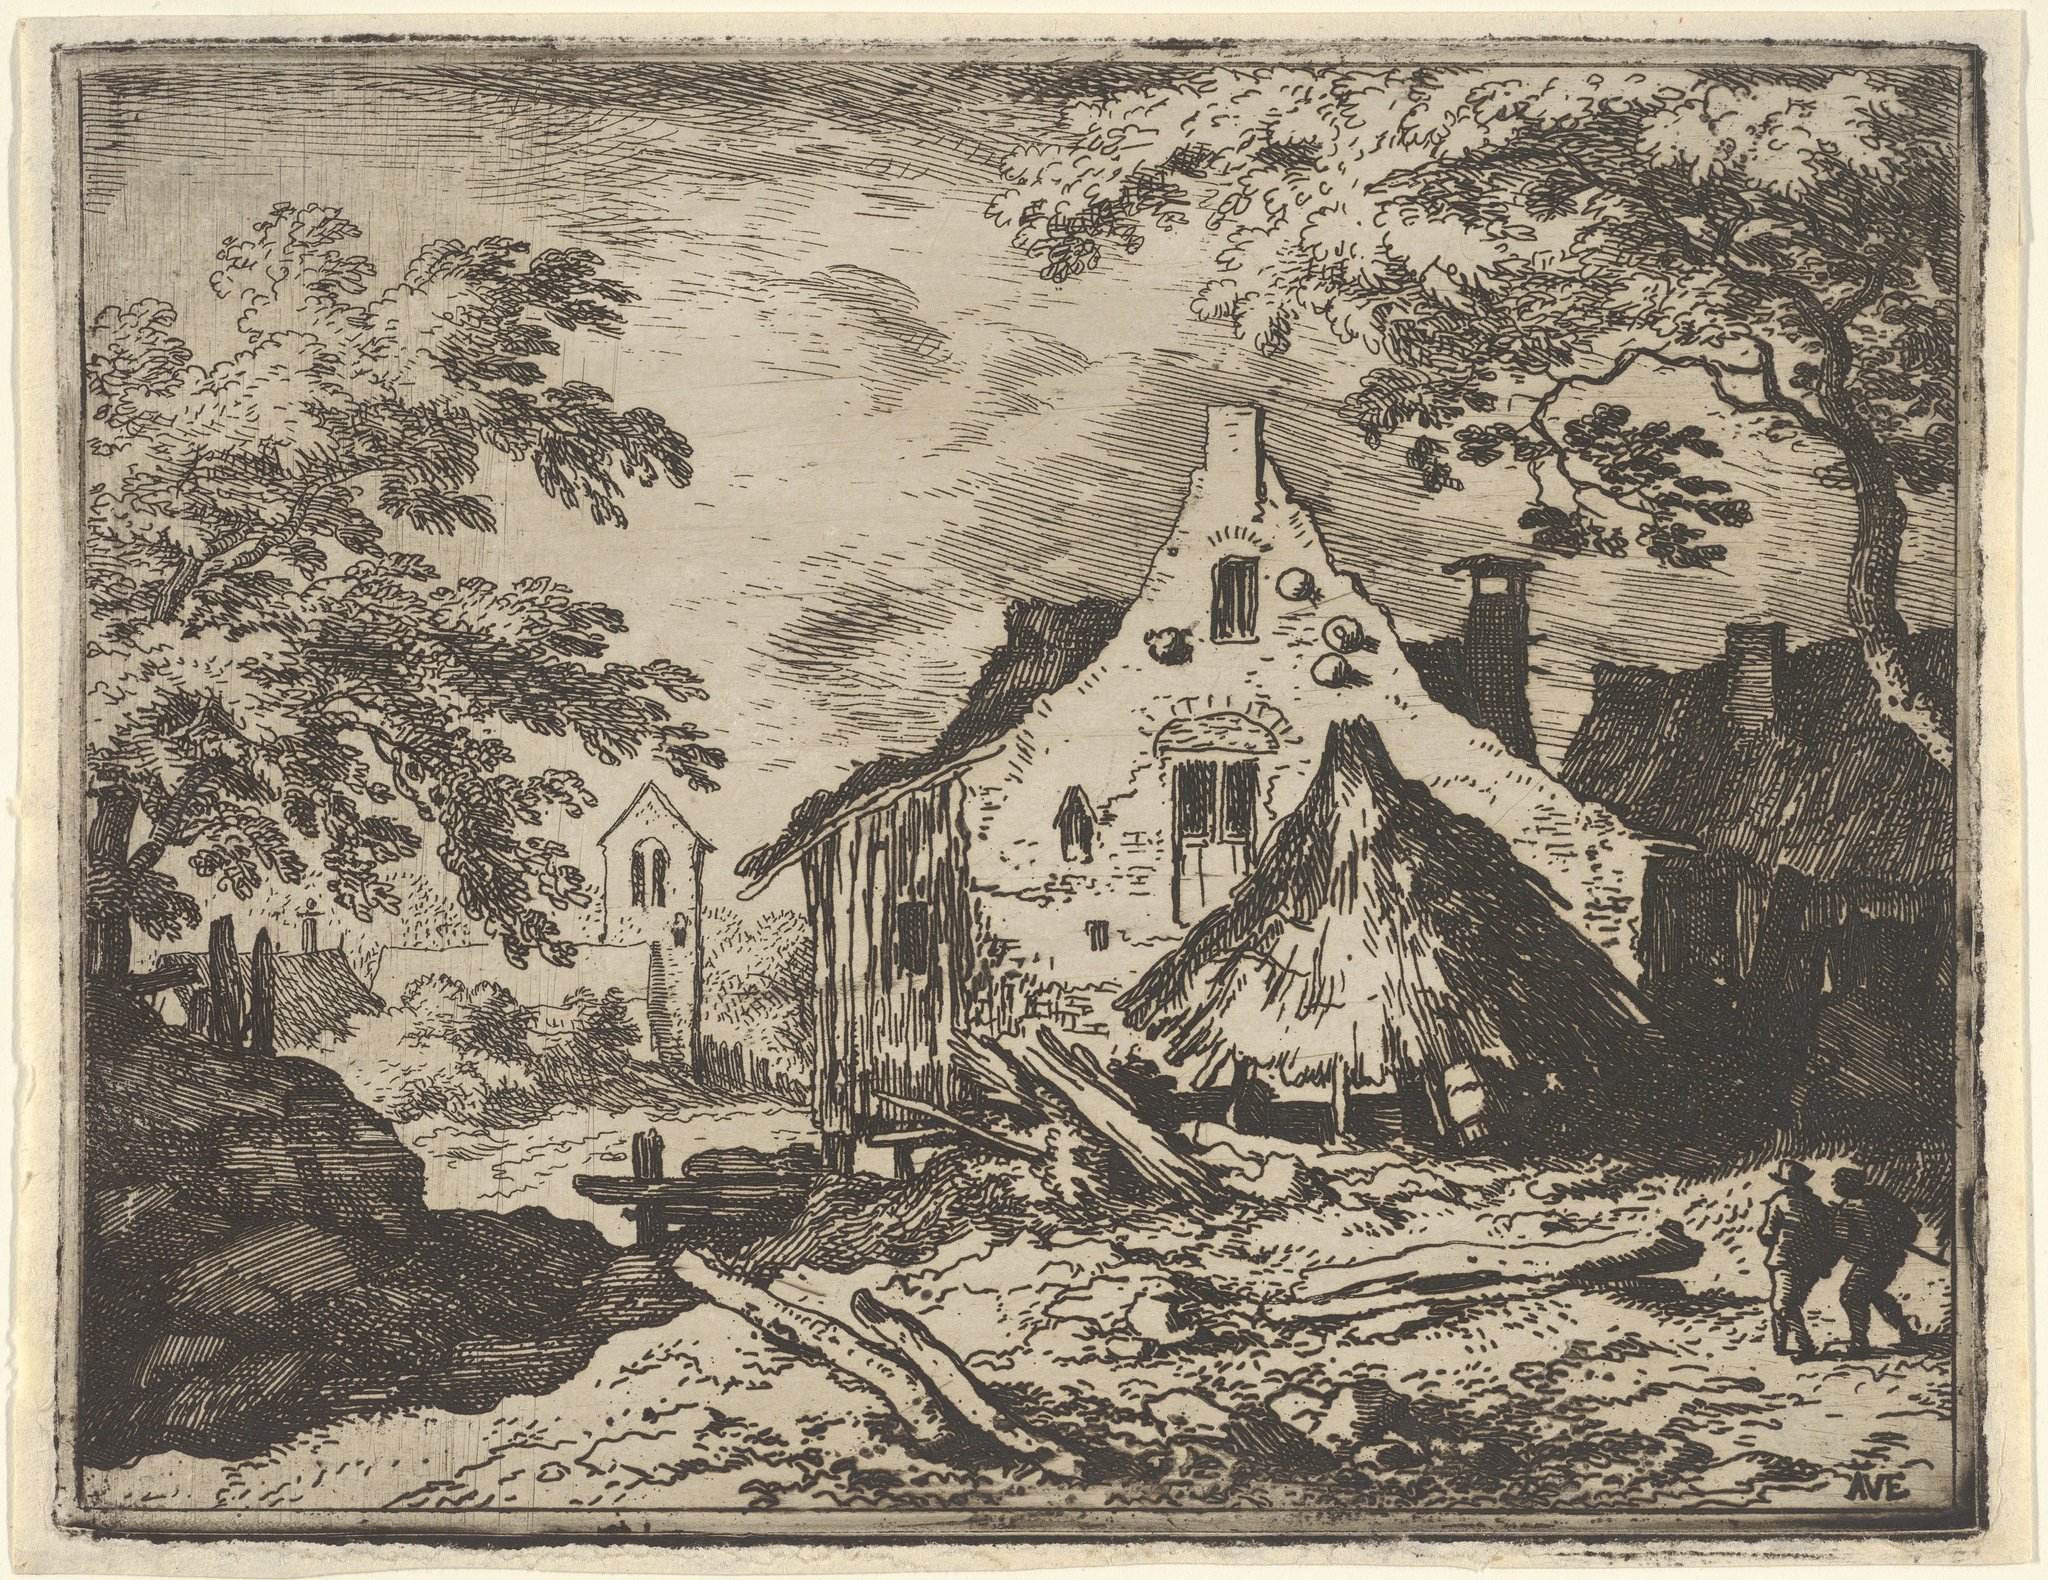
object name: print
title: The Haybarn with Movable Roof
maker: allart van everdingen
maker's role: artist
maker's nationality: dutch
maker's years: 1621-1675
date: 1621-1675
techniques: engraving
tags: barns